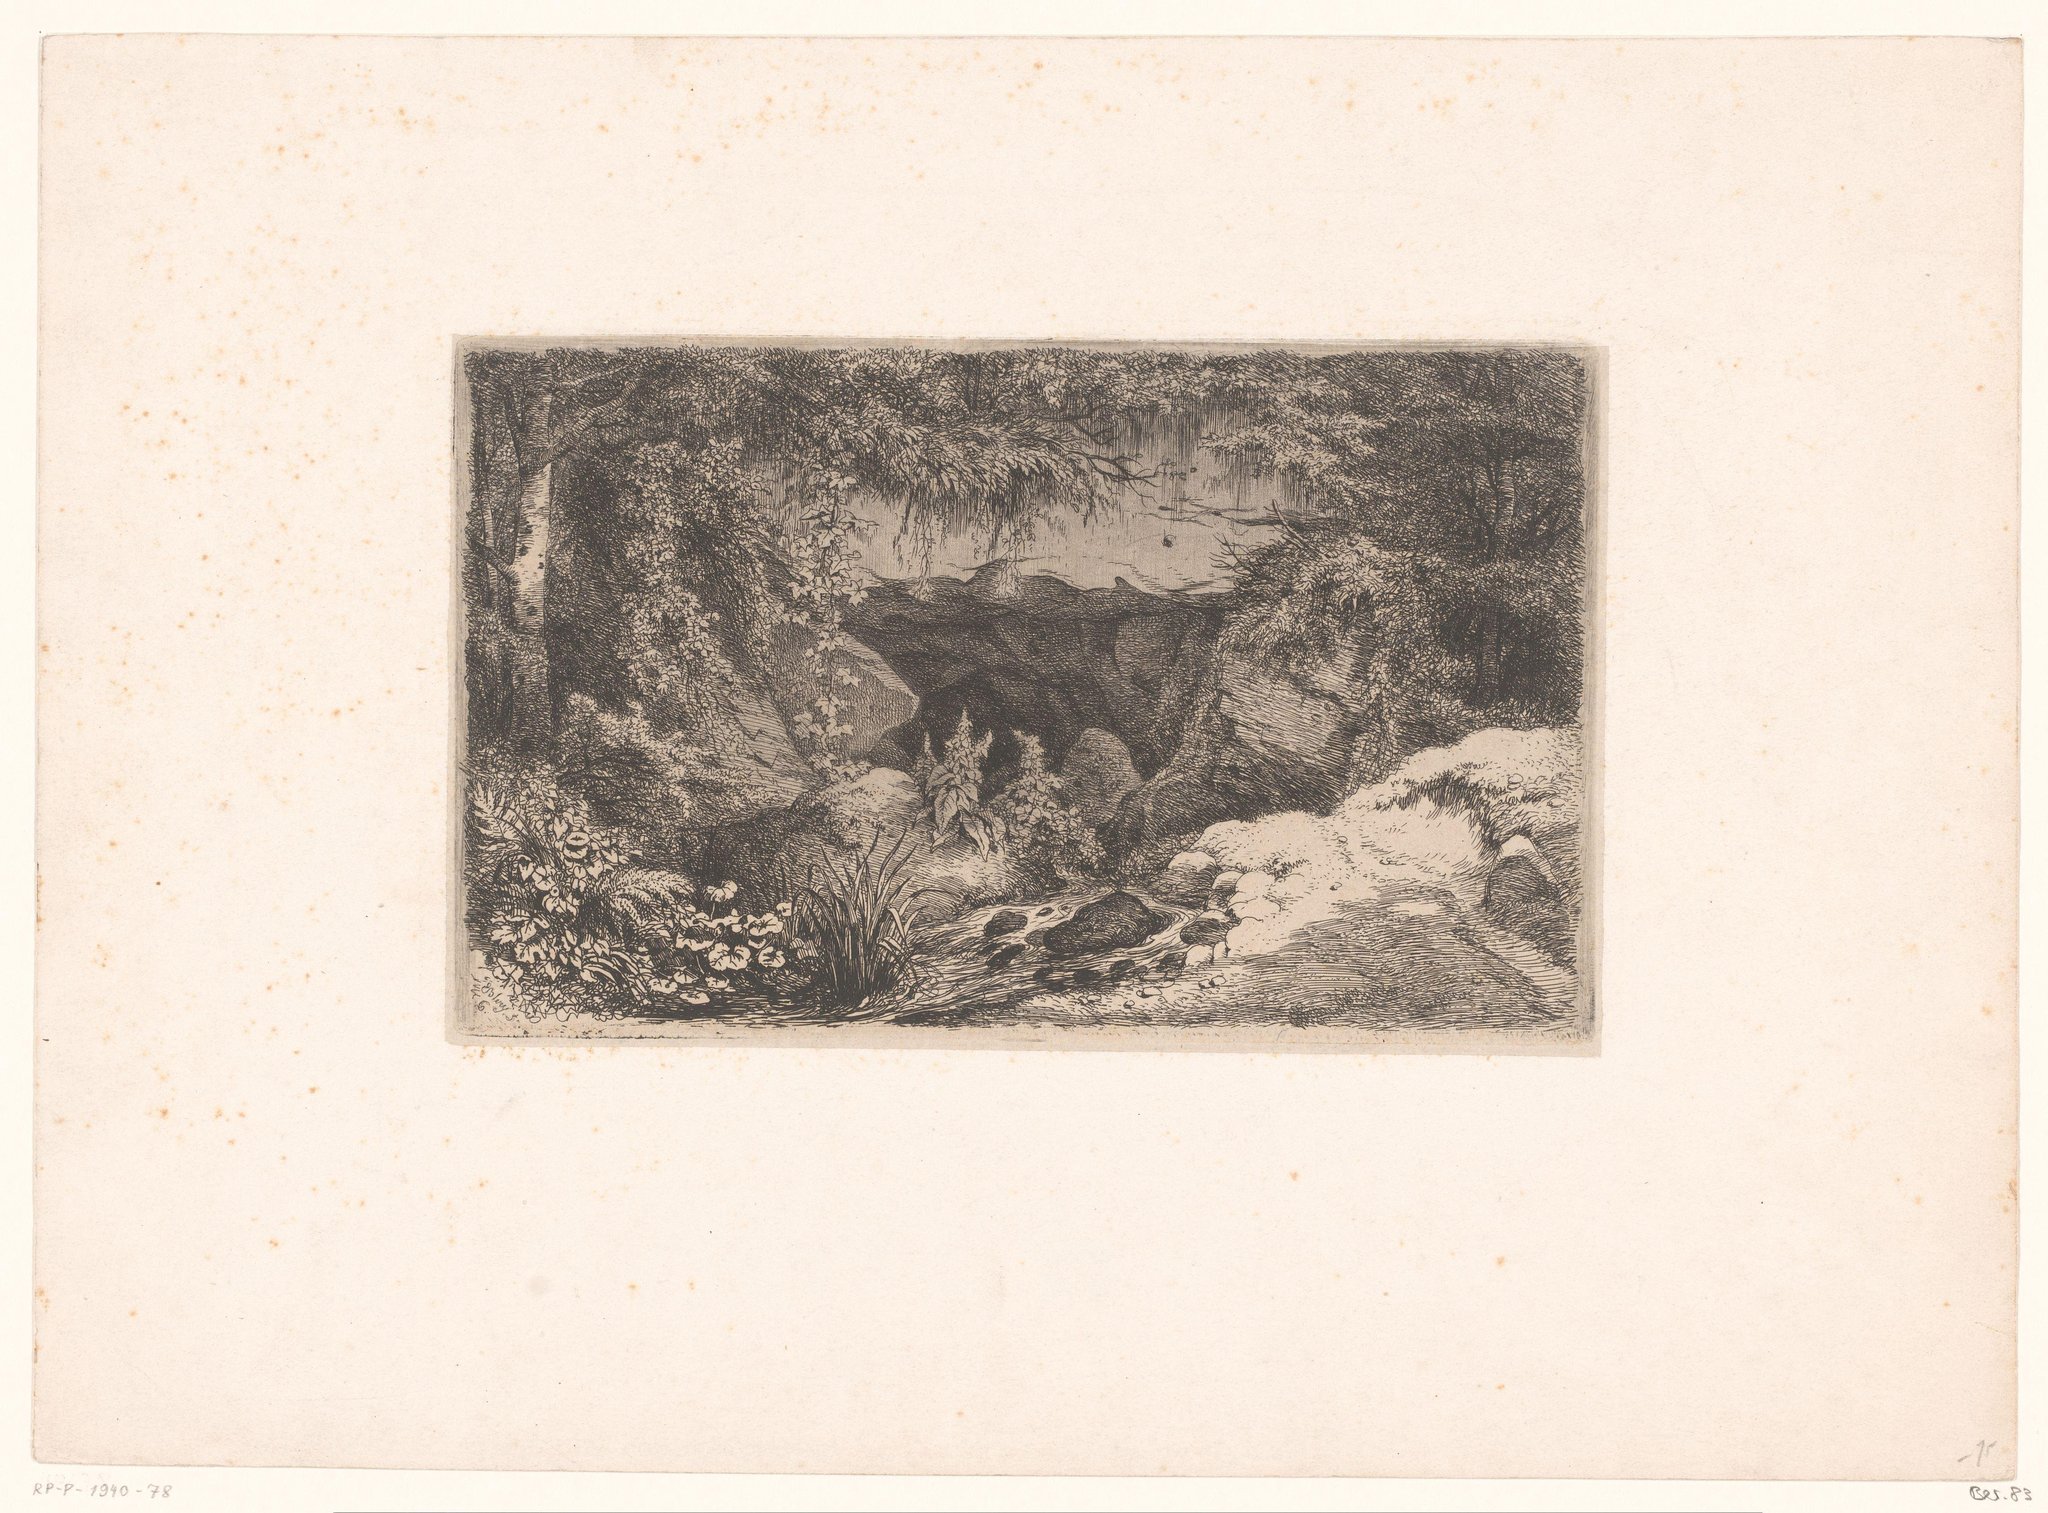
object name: print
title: La Source, ravin de Senlisse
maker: eugène bléry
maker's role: print maker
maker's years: 1805-1887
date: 1850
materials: paper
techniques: drypoint, engraving, etching, intaglio, roulette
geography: senlisse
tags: cave, grotto, spring, source of river or stream - hh - ideal landscapes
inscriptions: collector's mark: Lugt 2760, collector's mark: Lugt 2166